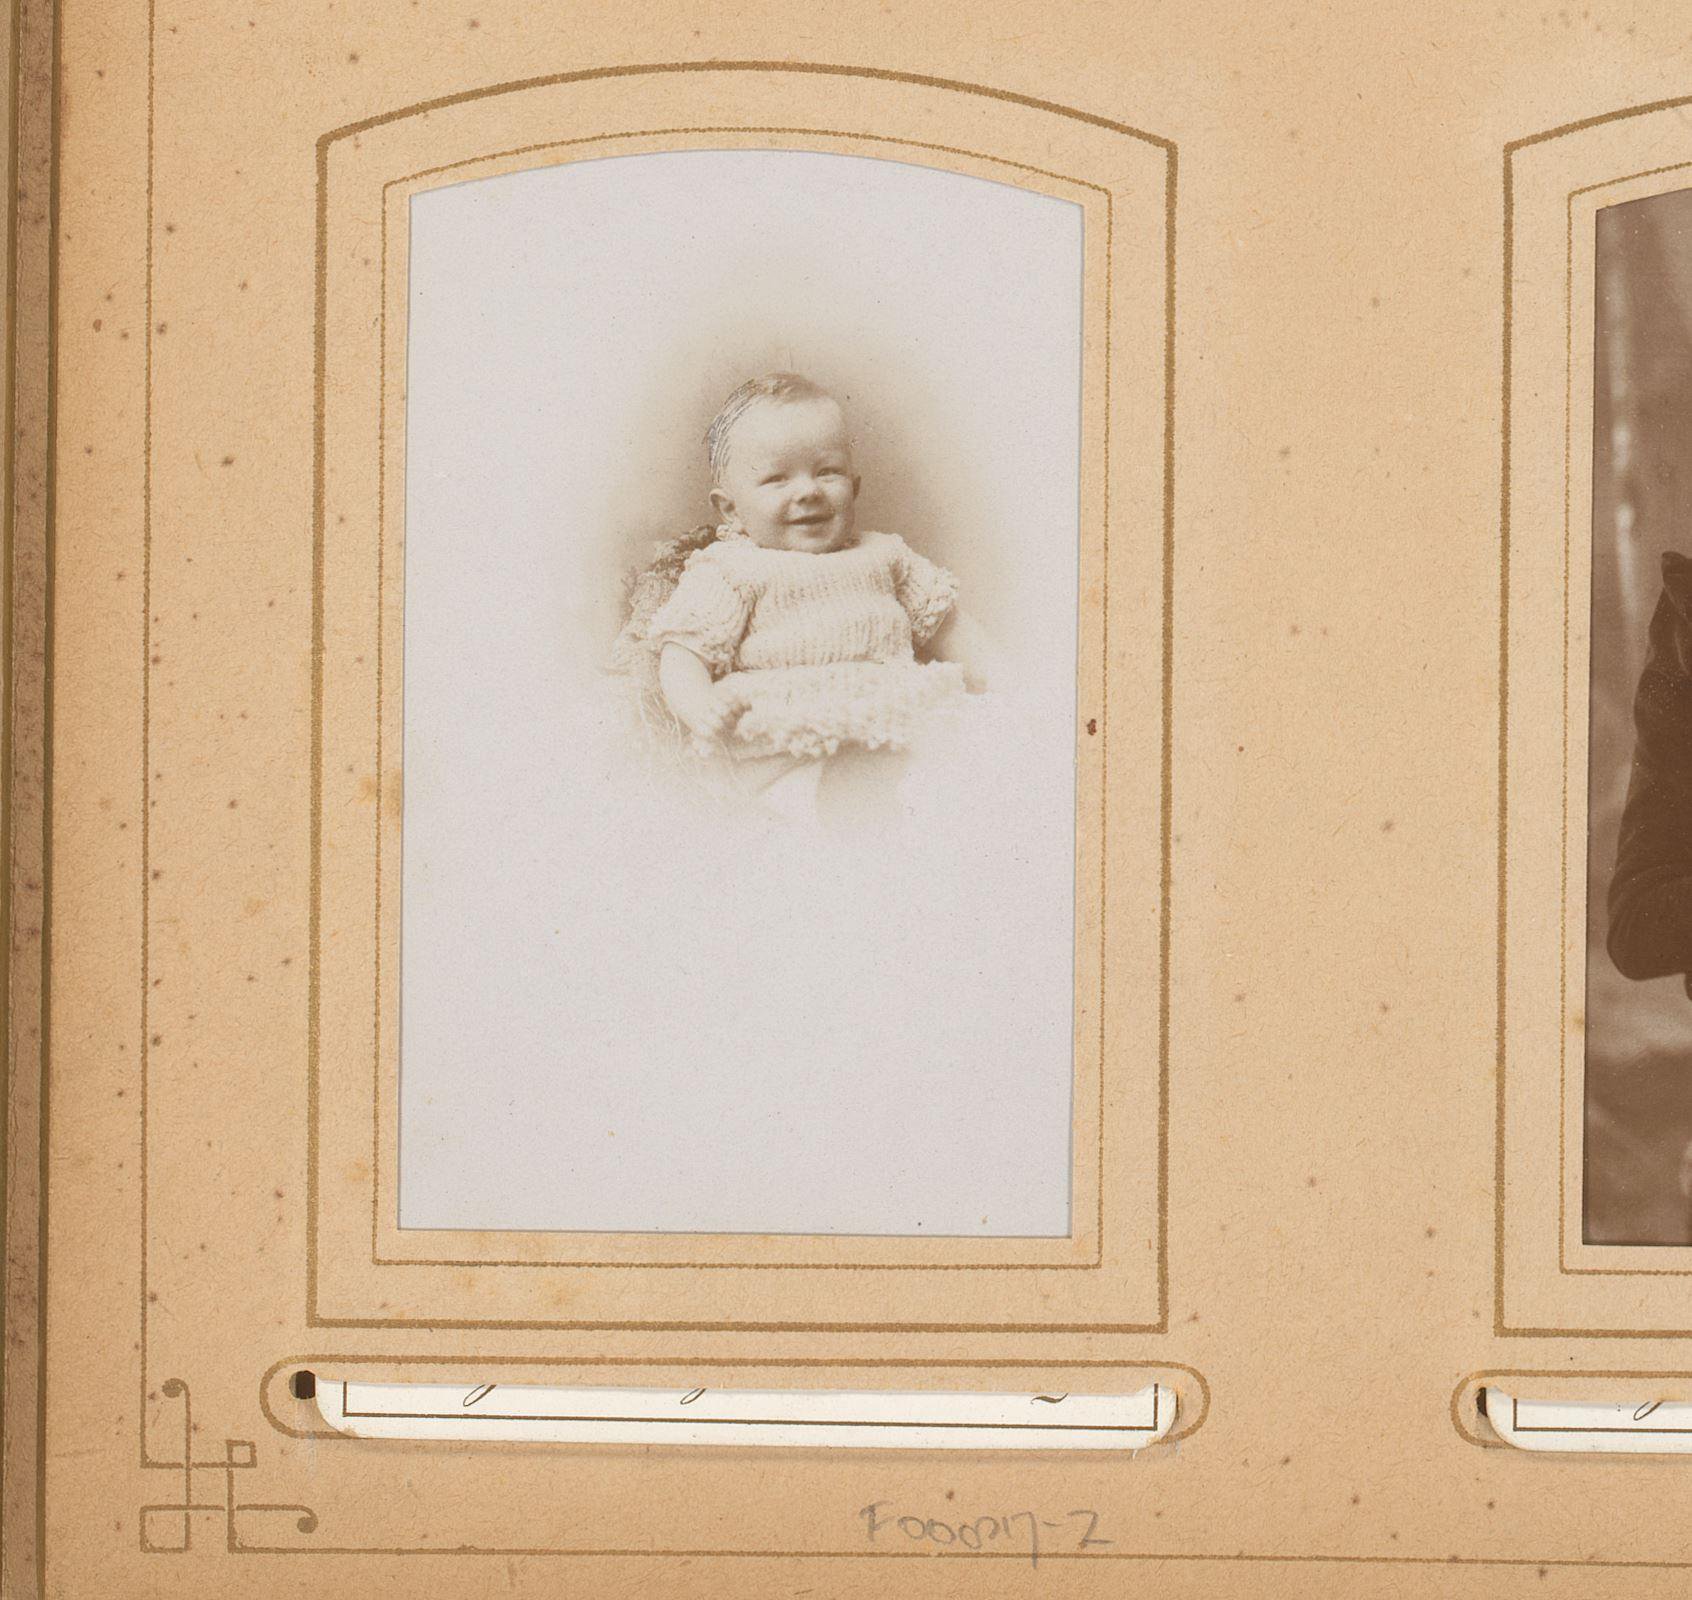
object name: album leaf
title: Portret van een zittende baby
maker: antonius johannes delboy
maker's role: fotograaf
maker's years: 1838-1904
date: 1890-1894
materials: cardboard, photographic support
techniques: collodion silver print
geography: the hague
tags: infant, baby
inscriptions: annotation: ‘Sinterklaas/ surprise v./ Tante [Tonnie]’, inscription: ‘A.J. Delboy/ Hofphotograaf/ Wagenstraat 126A/ Den Haag’